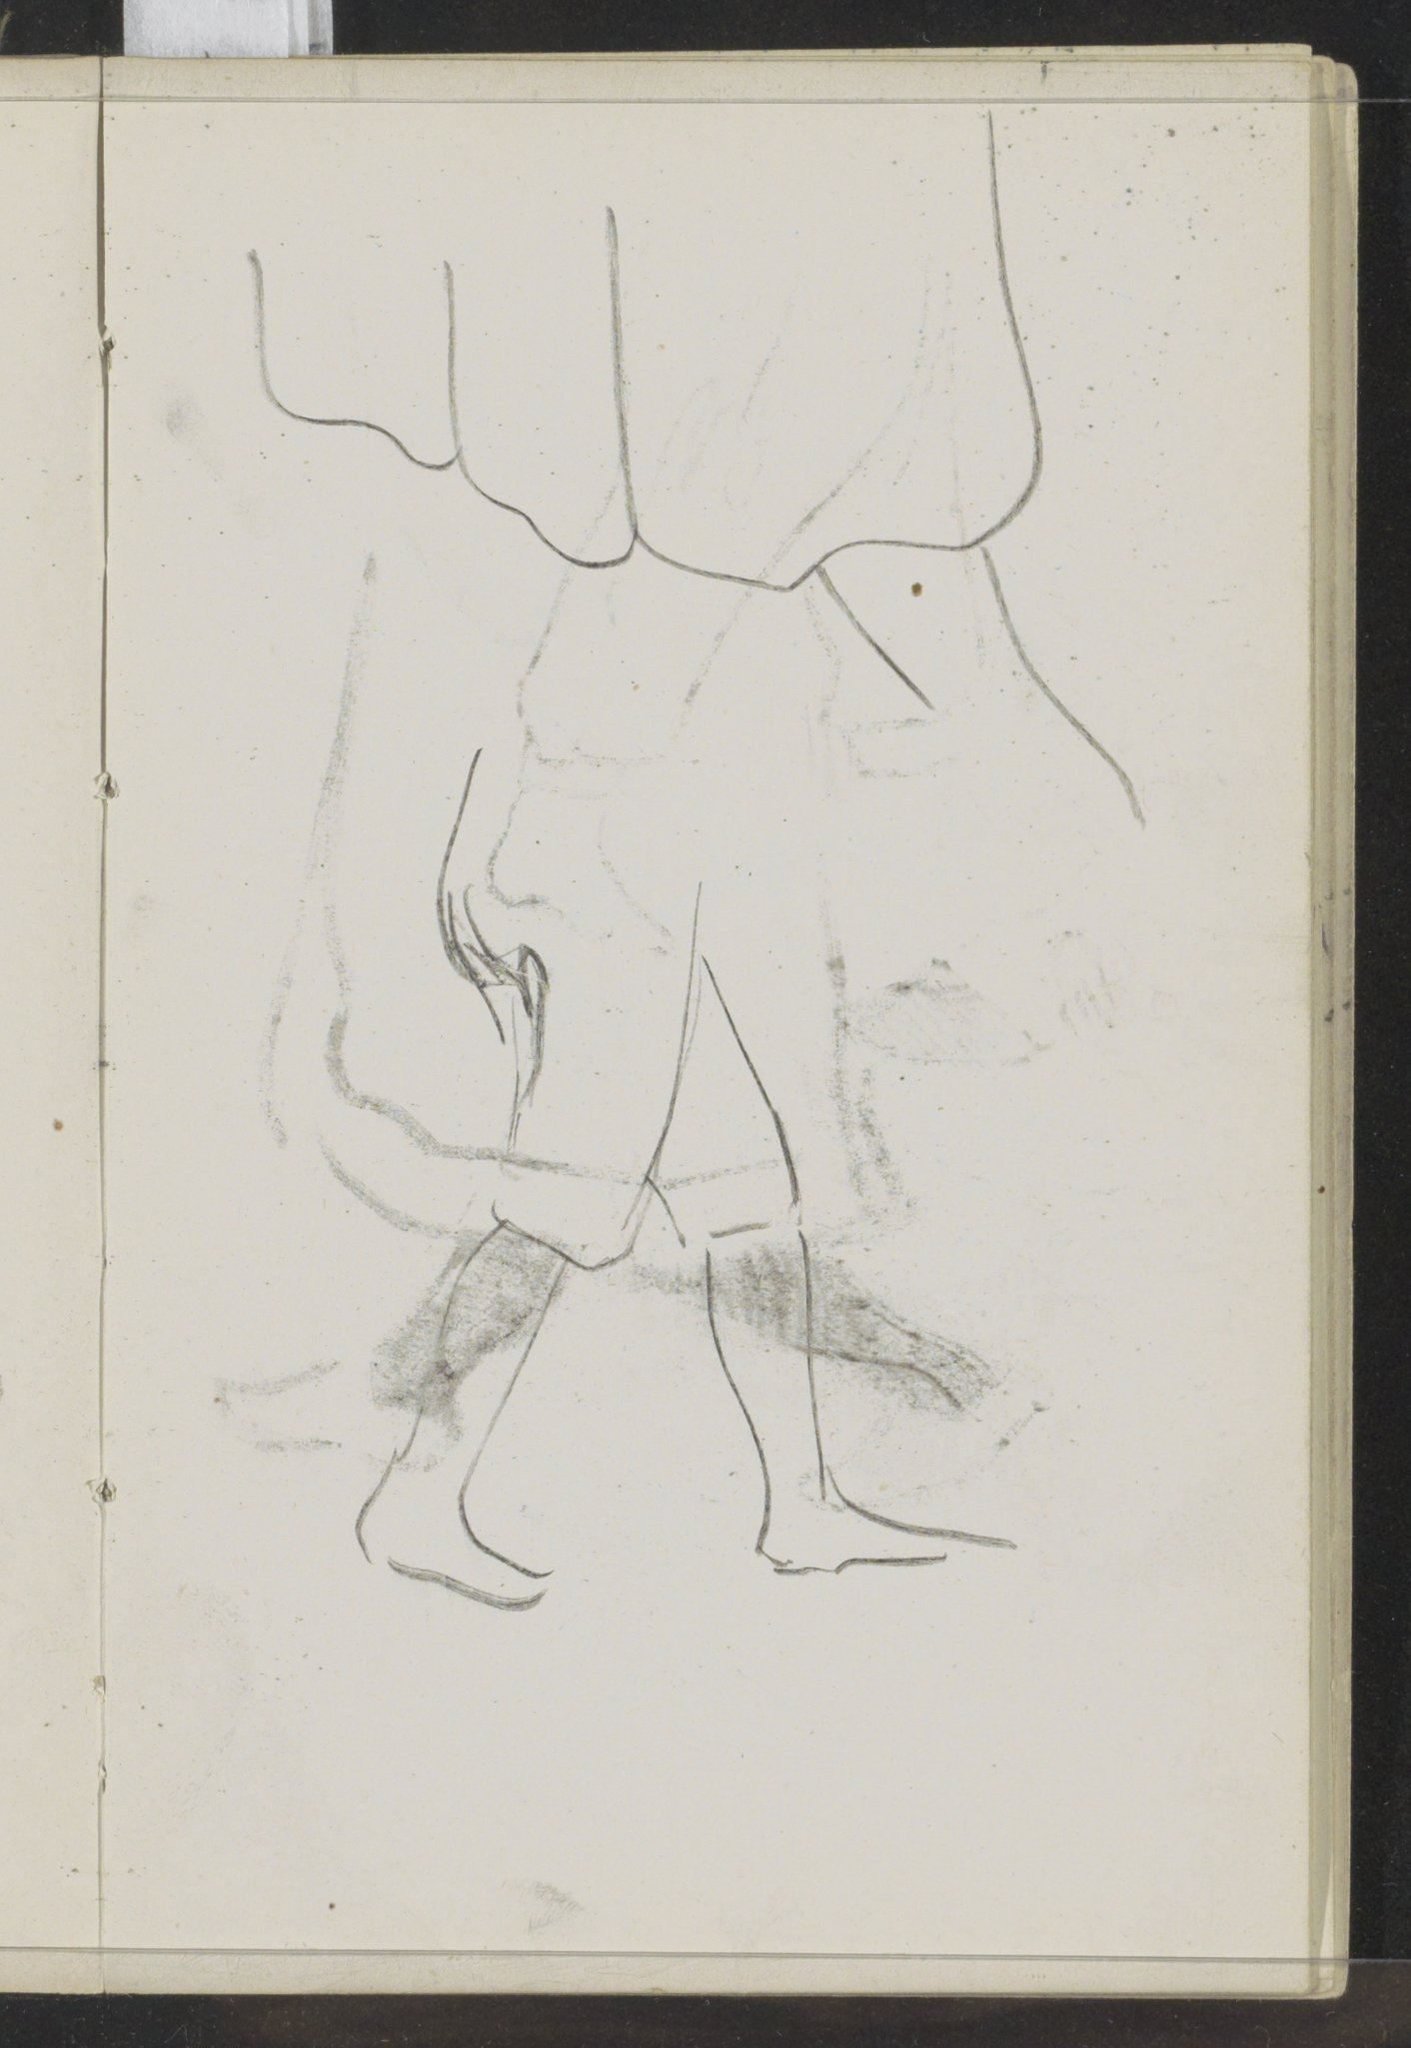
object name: sketchbook leaf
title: Paar lopende benen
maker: carel adolph lion cachet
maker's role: draughtsman, print maker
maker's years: 1864-1945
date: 1874-1945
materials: chalk, paper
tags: skirt, legs, walking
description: Tevens een studie van een rok. Blad 21 recto uit een schetsboek met 41 bladen.